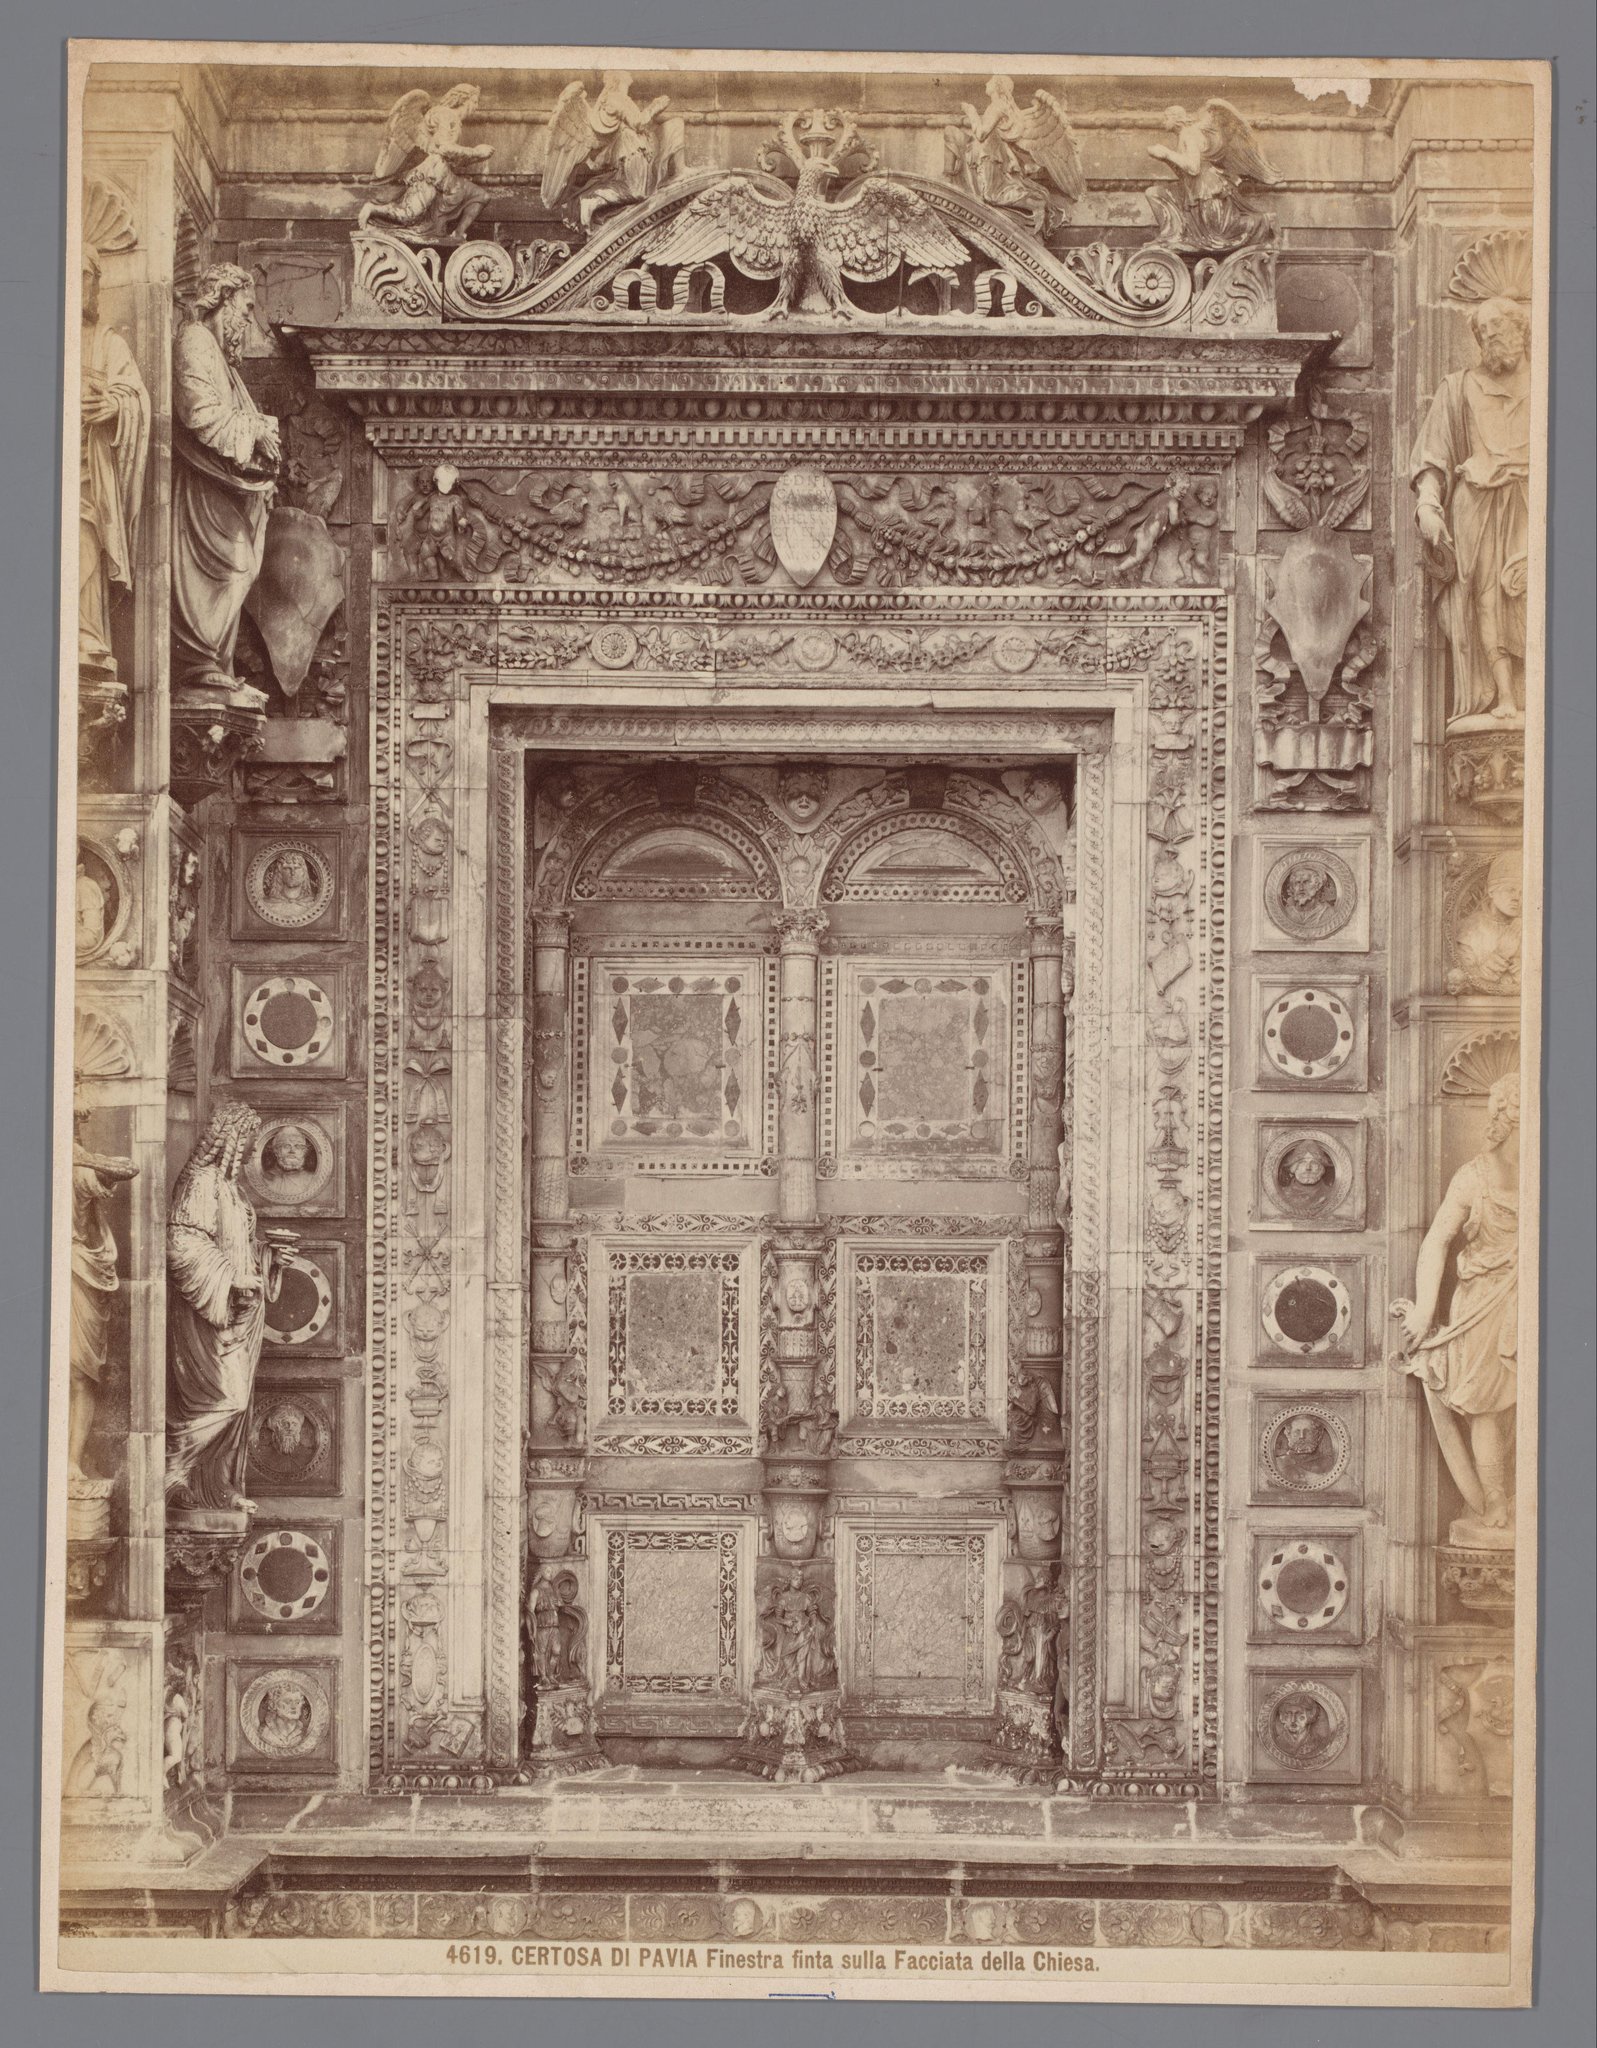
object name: photograph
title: Finestra finta sulla Facciata della Chiesa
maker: giacomo brogi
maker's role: fotograaf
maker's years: 1822-1881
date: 1864-1881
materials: cardboard, paper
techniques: albumen print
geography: pavia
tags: parts of church exterior and annexes: portal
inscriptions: inscription: ‘Brogi’, number: ‘4619.’